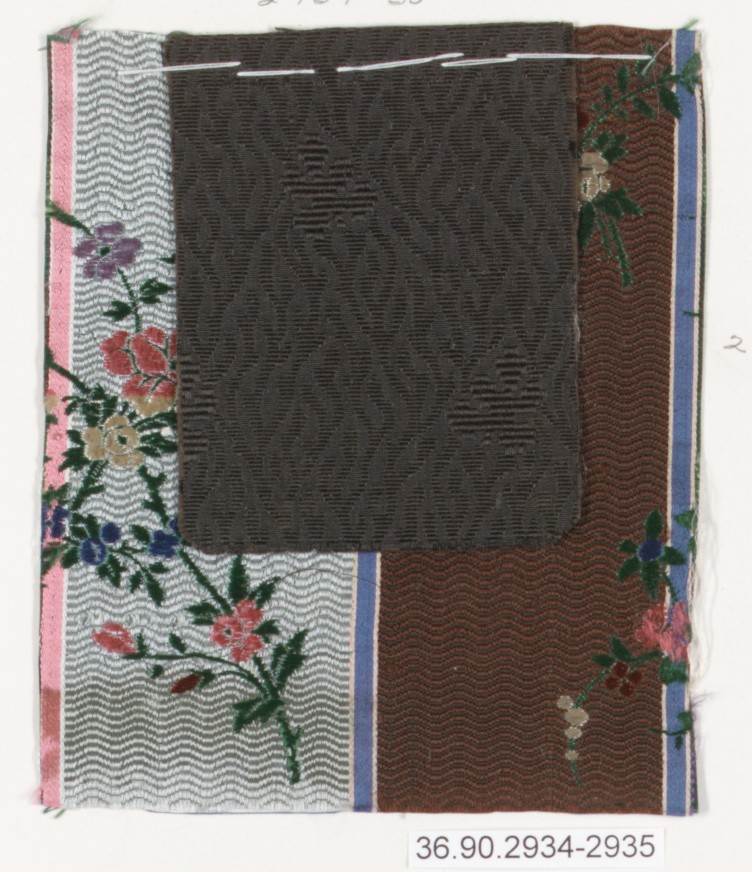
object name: piece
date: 1801-1900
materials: silk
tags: flowers,leaves